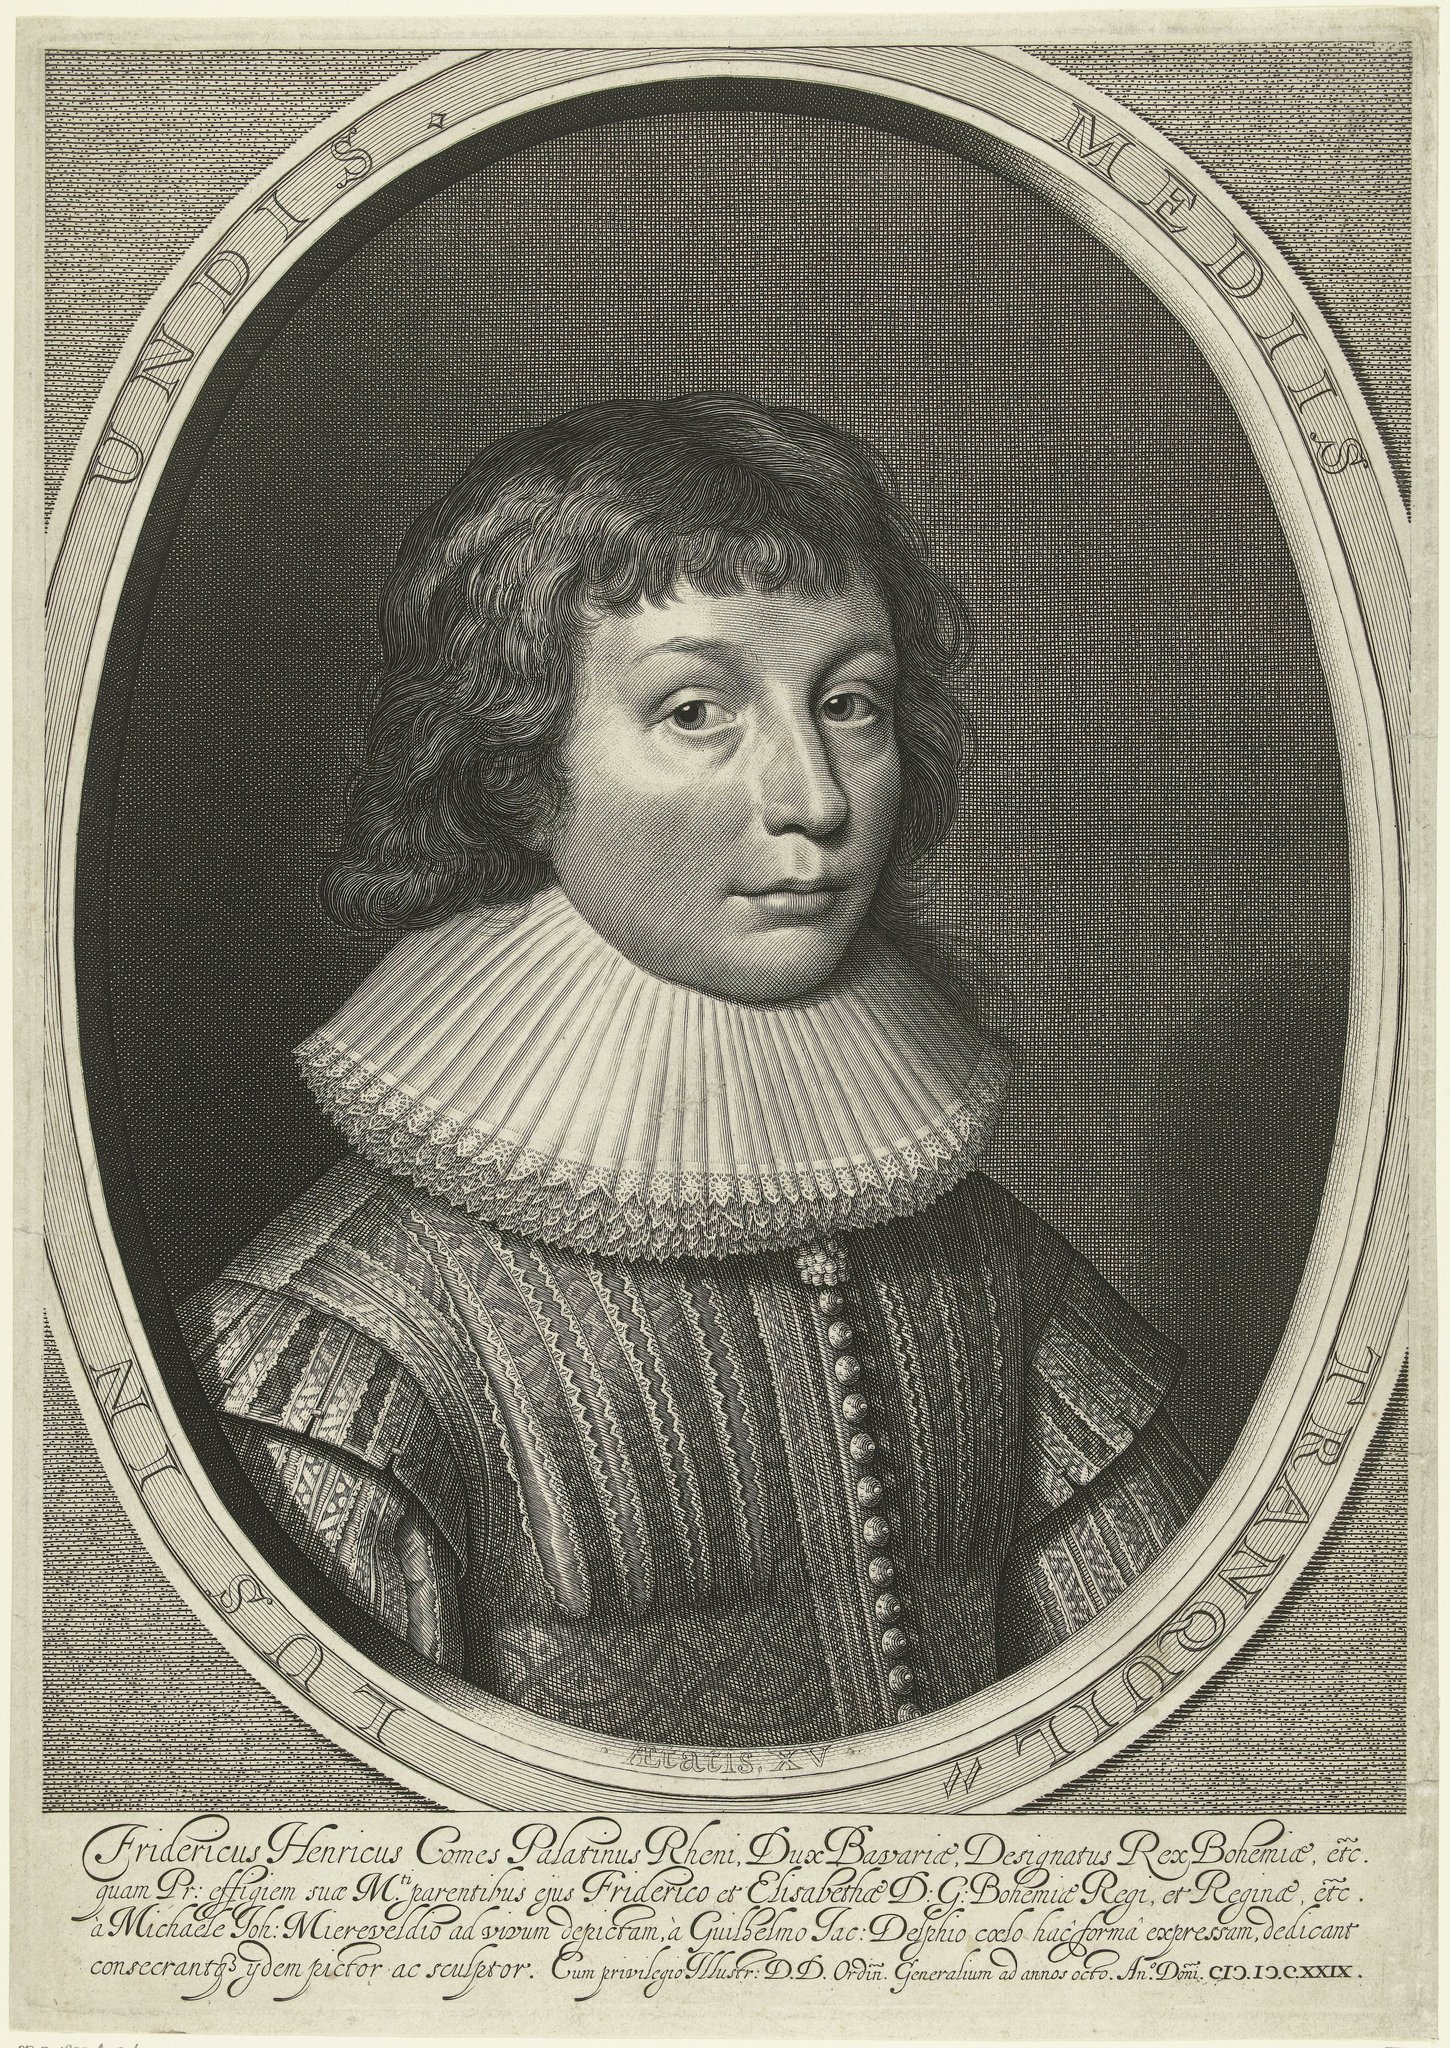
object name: print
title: Portret van Frederik Hendrik van de Palts, zoon van de Koning van Bohemen op 15-jarige leeftijd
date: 1629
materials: paper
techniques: engraving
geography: delft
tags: neck-gear: collar (+ children's clothes)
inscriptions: collector's mark: Lugt 2228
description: Portret van Frederik Hendrik van de Palts, zoon van de Koning van Bohemen, op 15-jarige leeftijd. Borststuk met plooikraag in ovale omlijsting met Latijns motto. In ondermarge Latijns opschrift in vier regels.